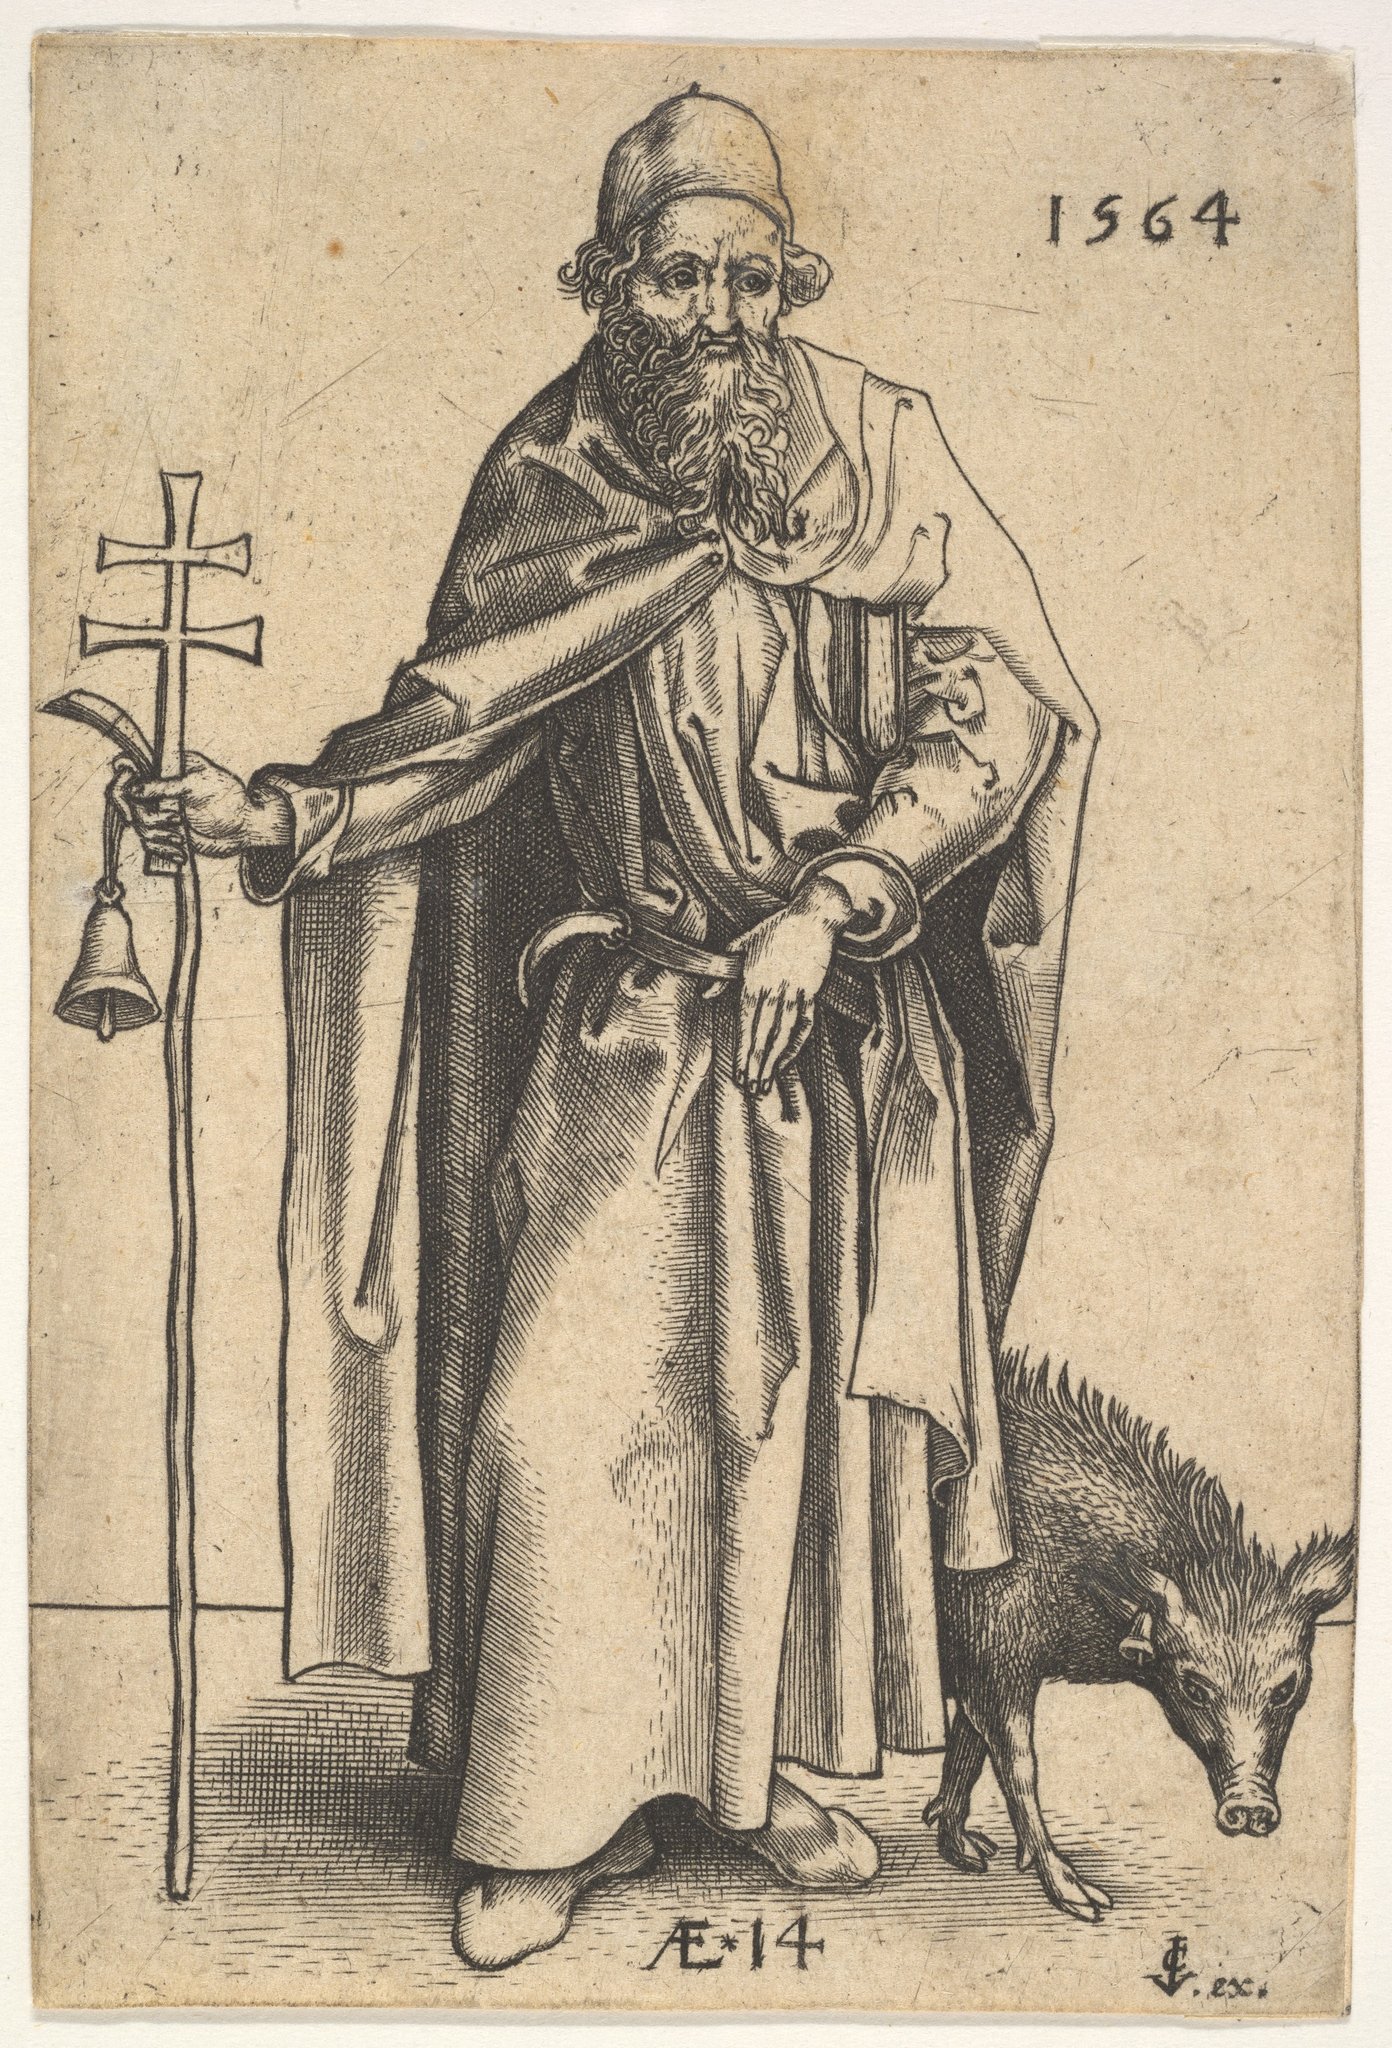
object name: print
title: Saint Anthony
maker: hieronymus wierix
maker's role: artist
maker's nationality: netherlandish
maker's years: 1553-1619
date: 1564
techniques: engraving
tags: pigs,saint anthony